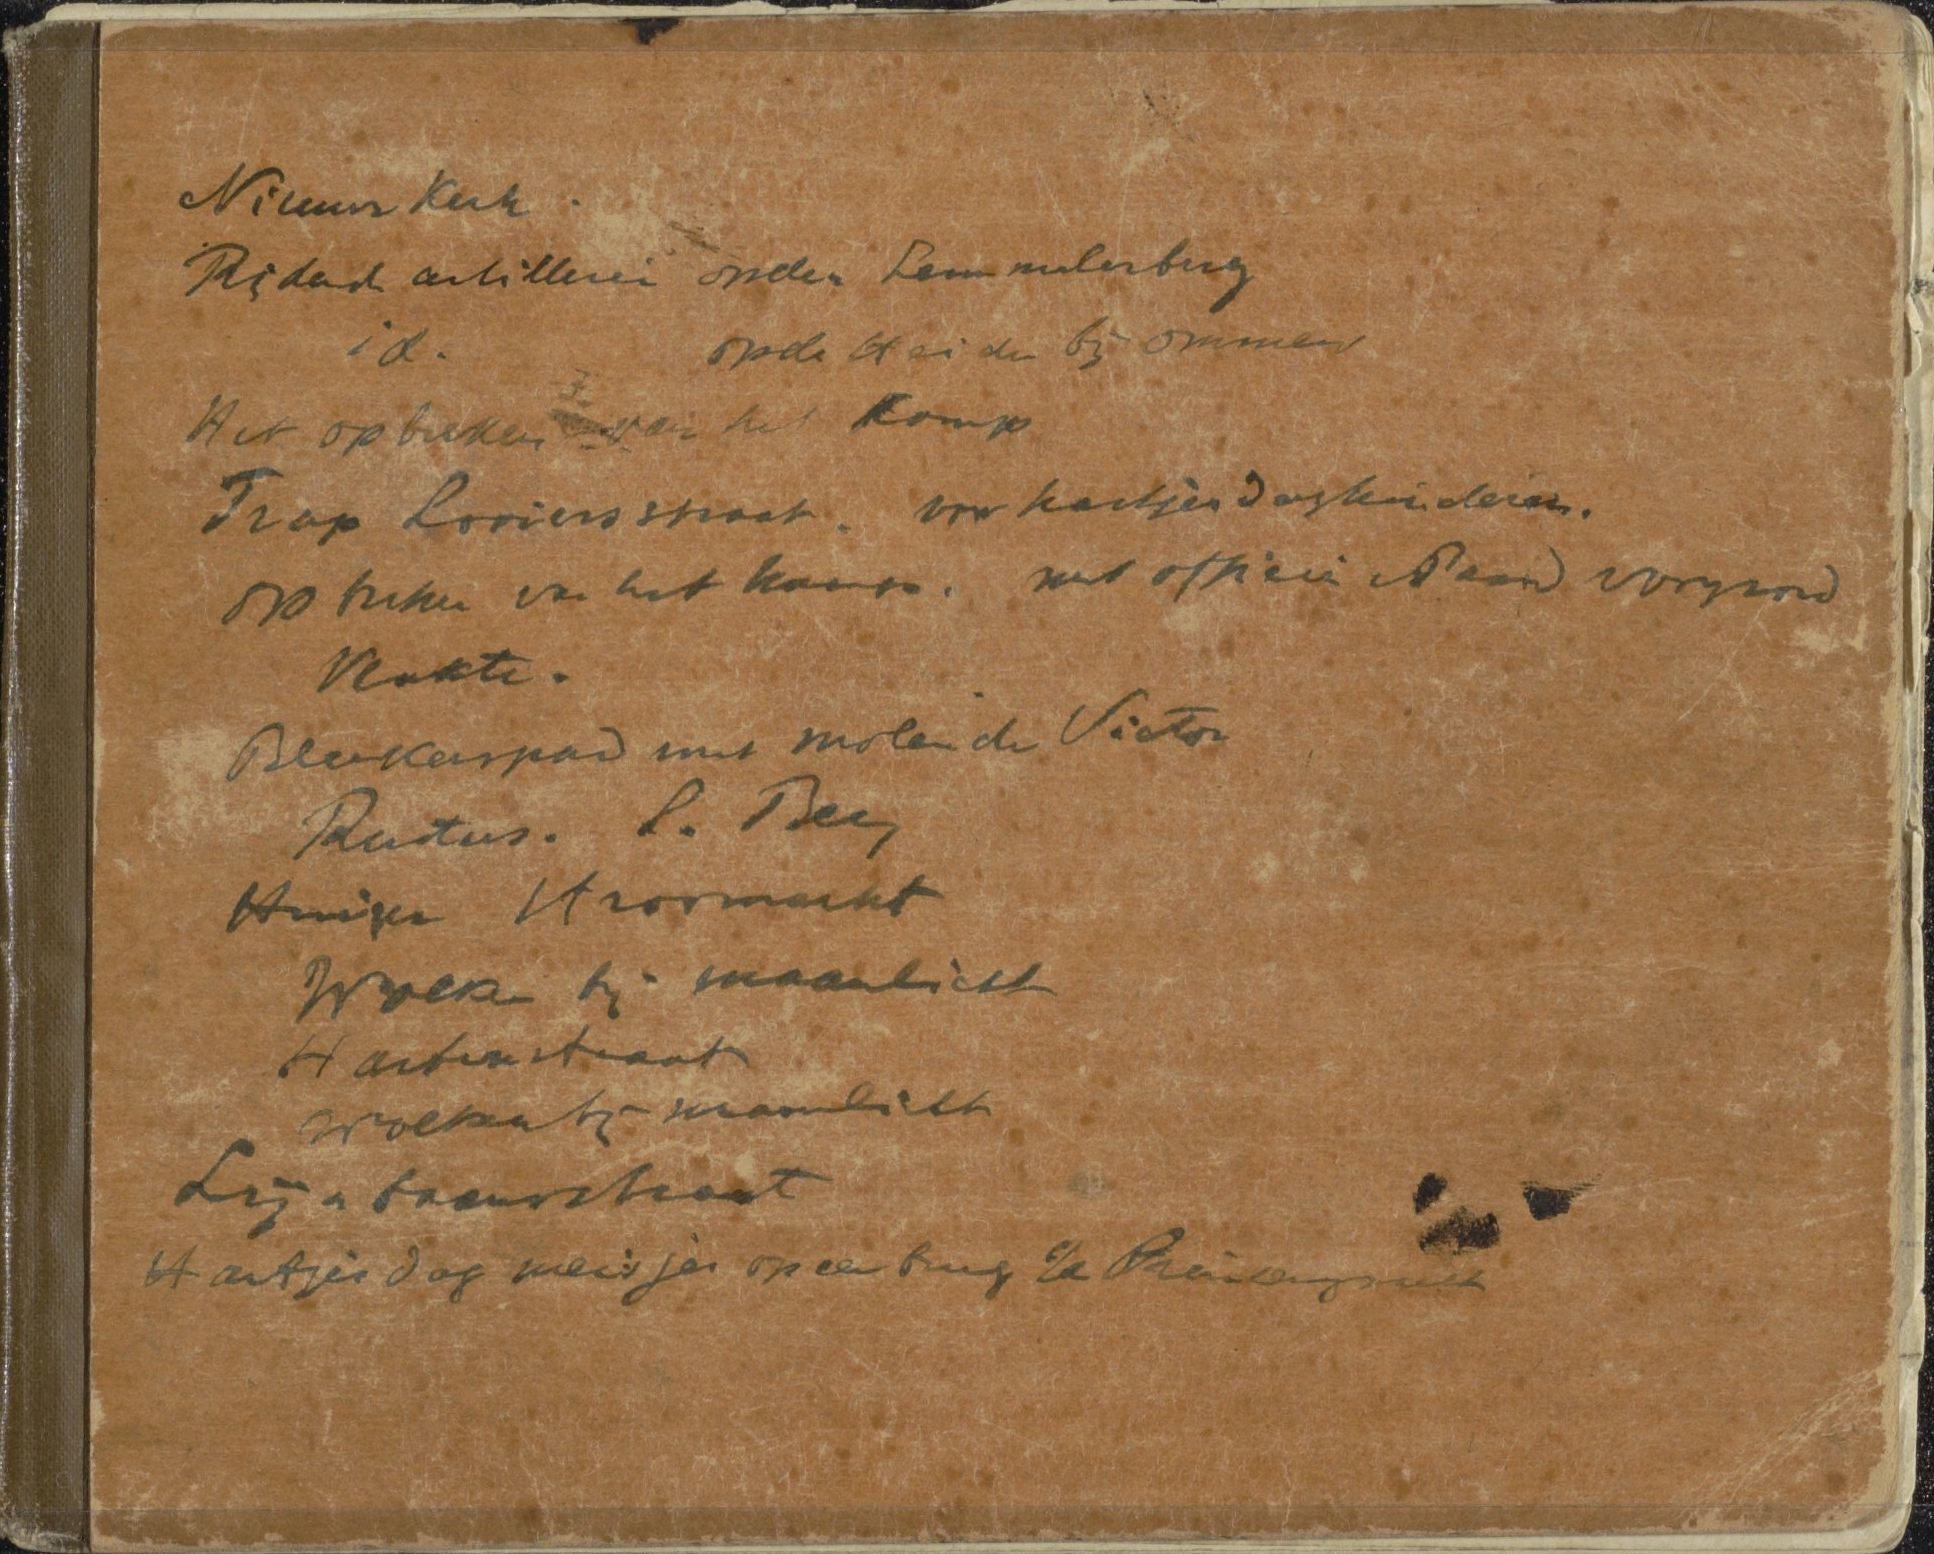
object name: sketchbook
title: Schetsboek met 32 bladen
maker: george hendrik breitner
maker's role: draughtsman, painter, print maker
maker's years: 1857-1923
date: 1885-1898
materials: cardboard, chalk, linen, paper, pencil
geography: amsterdam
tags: land forces (+ artillery), cat, street, amsterdam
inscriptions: annotation: ‘Nieuwe Kerk/ Rijdende artillerie op de Lemmelerberg [sic]/ id. op de heide bij Ommen/ Het opbreken van het kamp/ Trap Looiersstraat. voor hartjesdag kinderen./ opbreken van het kamp. met officier paard voorgrond/ Vlakte./ Bleekerspad met molen de Victor/ Ruiters L. Berg/ Huisjes Stroomarkt/ Wolken bij maanlicht/ Hartenstraat/ Wolken bij maanlicht/ Lijnbaanstraat/ Hartjesdag meisjes op een brug b/d Prinsengracht’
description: Schetsboek bestaande uit 32 bladen met gezichten te Amsterdam, artillerie, katten en een ingeplakte foto.